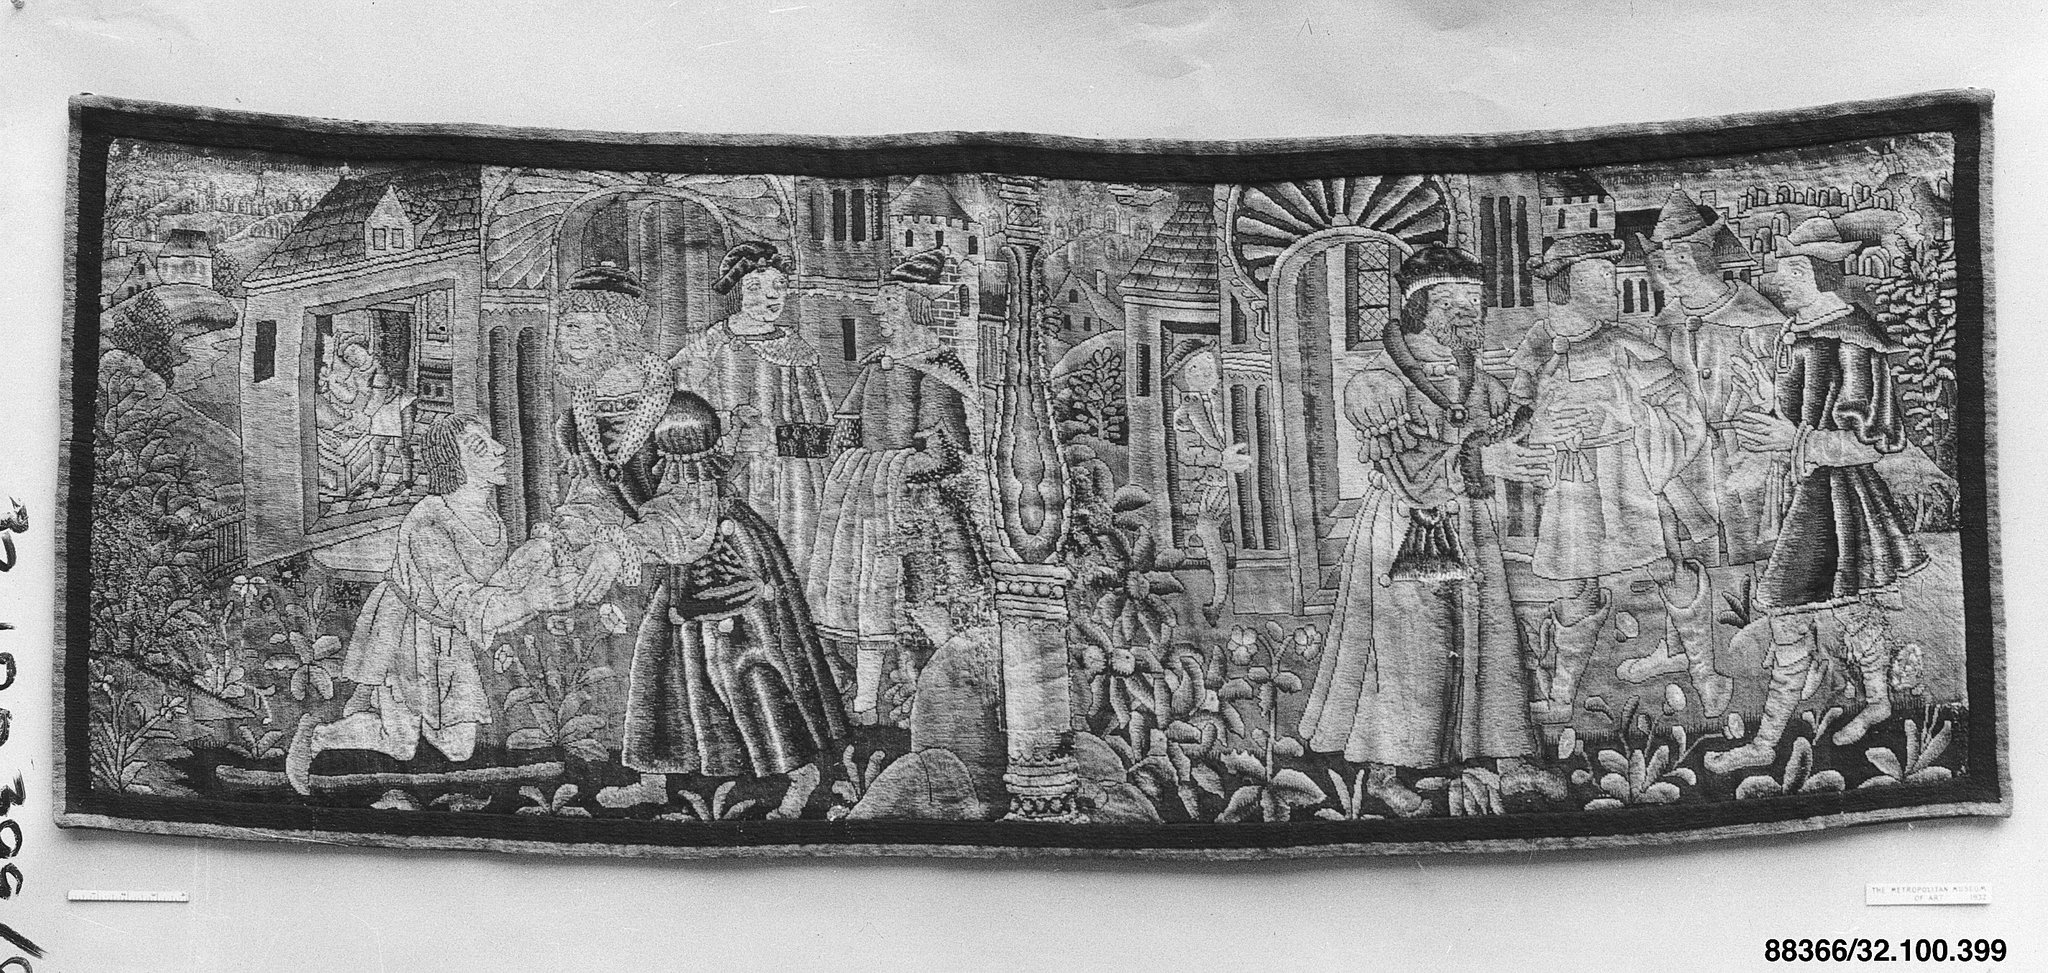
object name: valance fragment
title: Part of a valance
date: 1567-1600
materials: canvas, wool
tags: houses,men,women